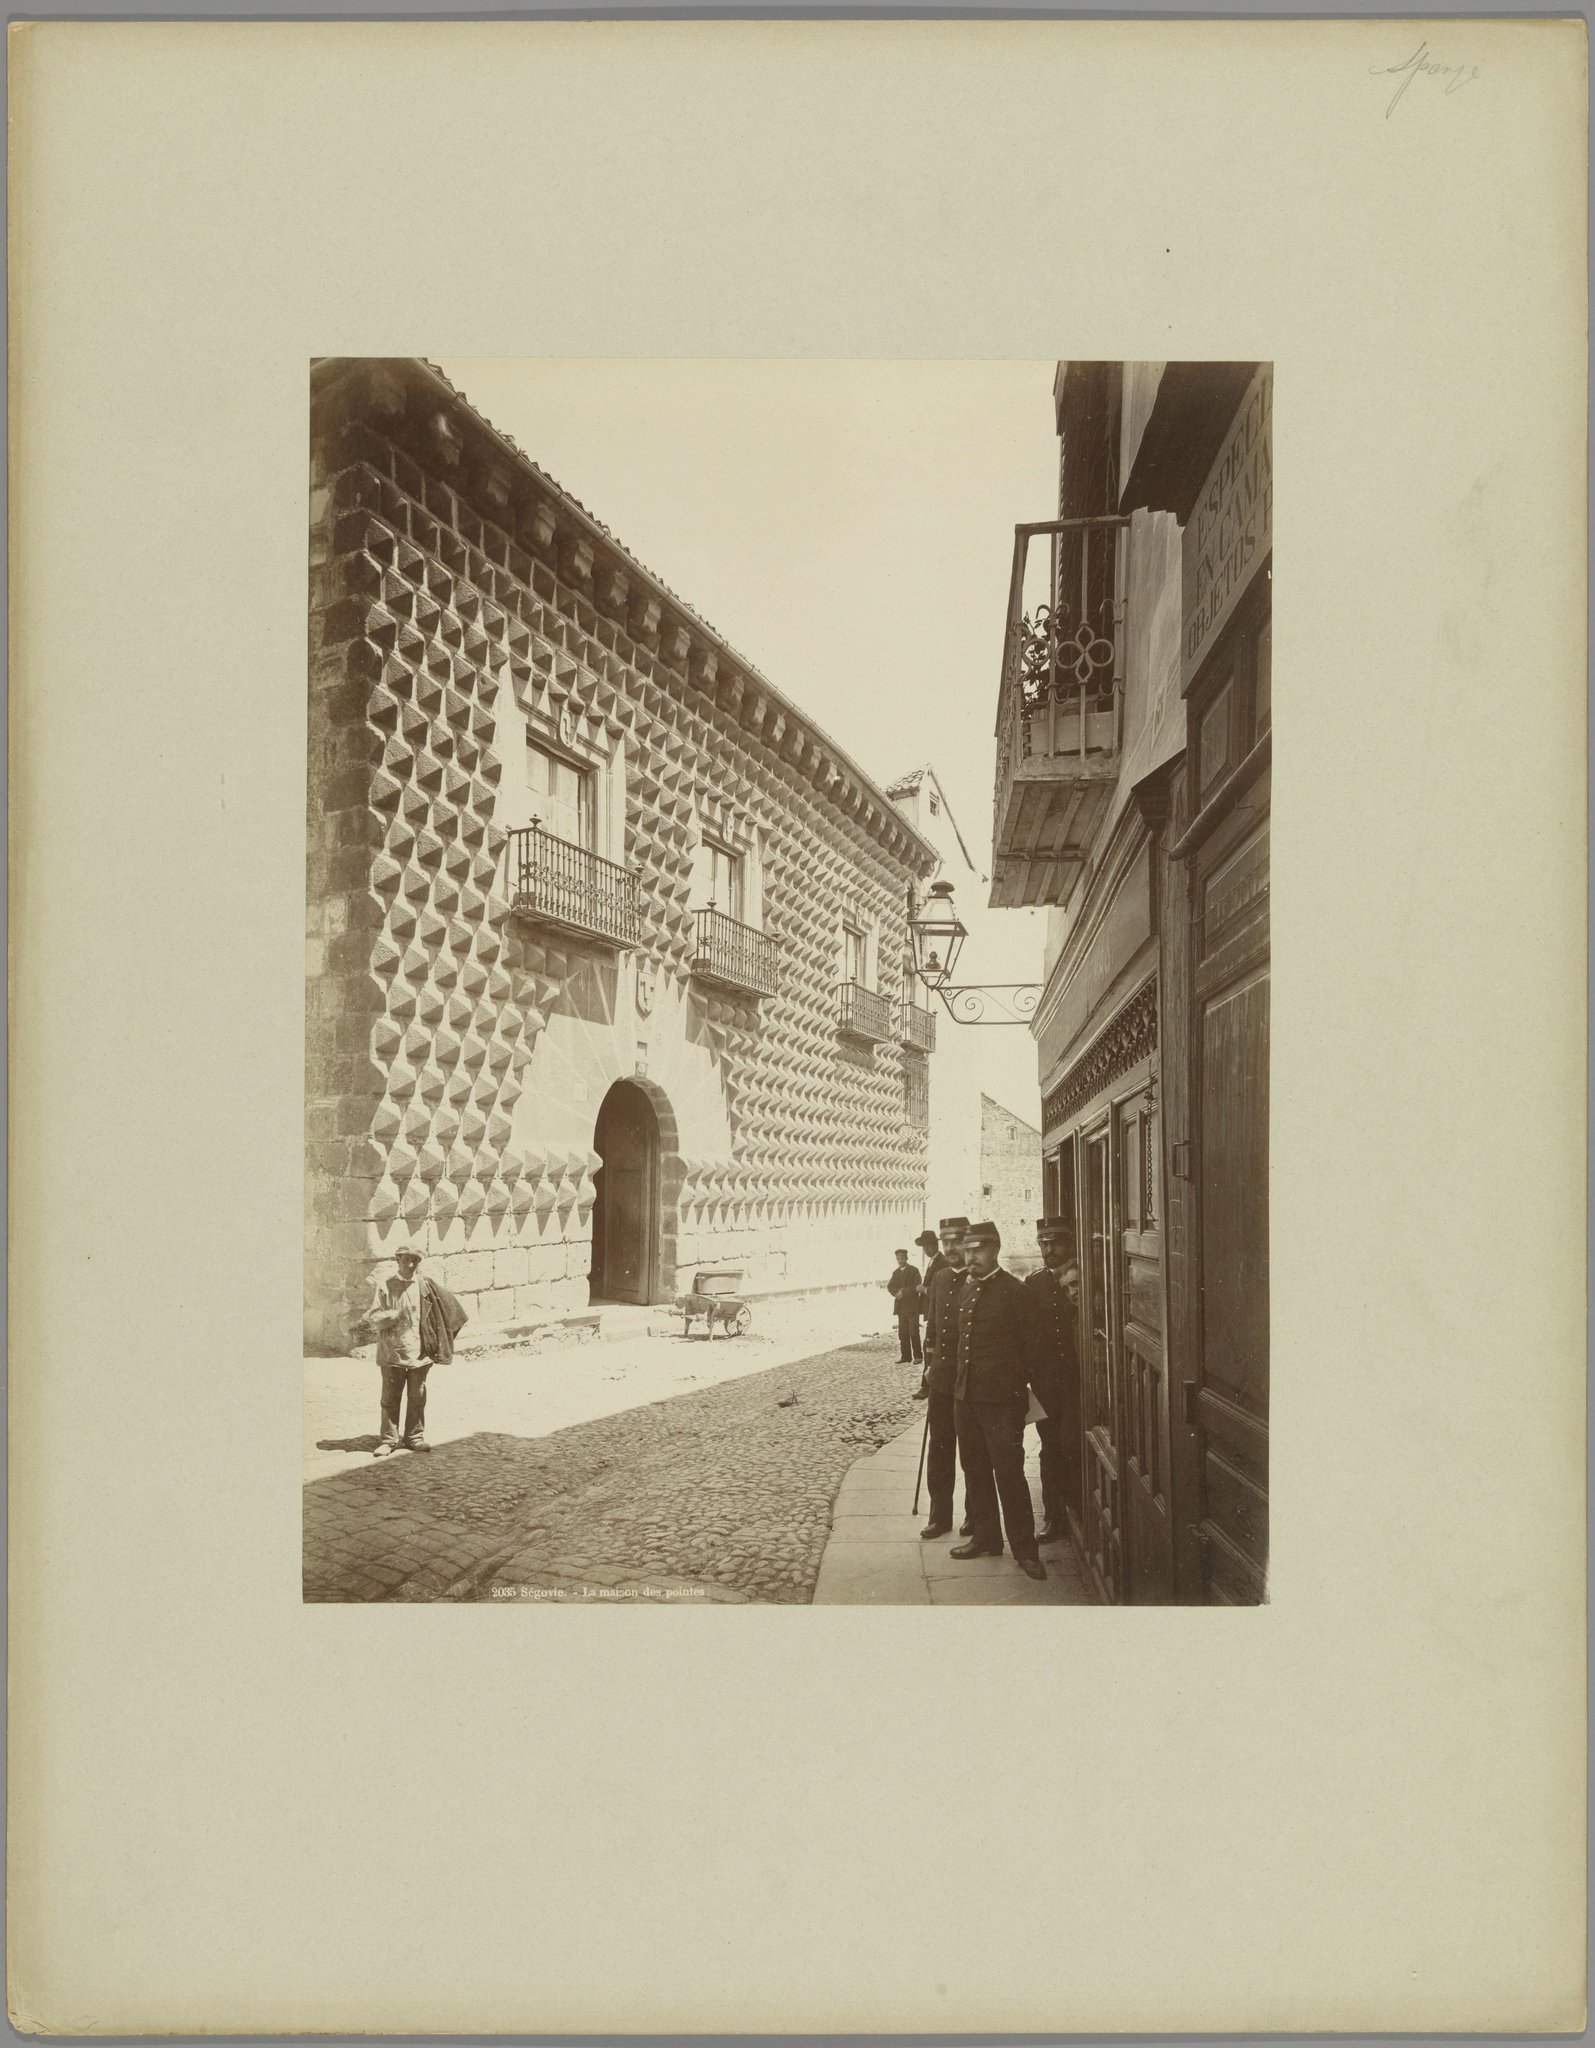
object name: photograph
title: Ségovie. - La maison des pointes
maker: Anonymous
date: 1875-1900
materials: cardboard, photographic support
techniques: albumen print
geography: segovia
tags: hand-cart, hôtel, i.e. small palace in city, (military) uniforms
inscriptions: collector's mark: Lugt 3937, number: ‘2035’, inscription: ‘B.F.K.’